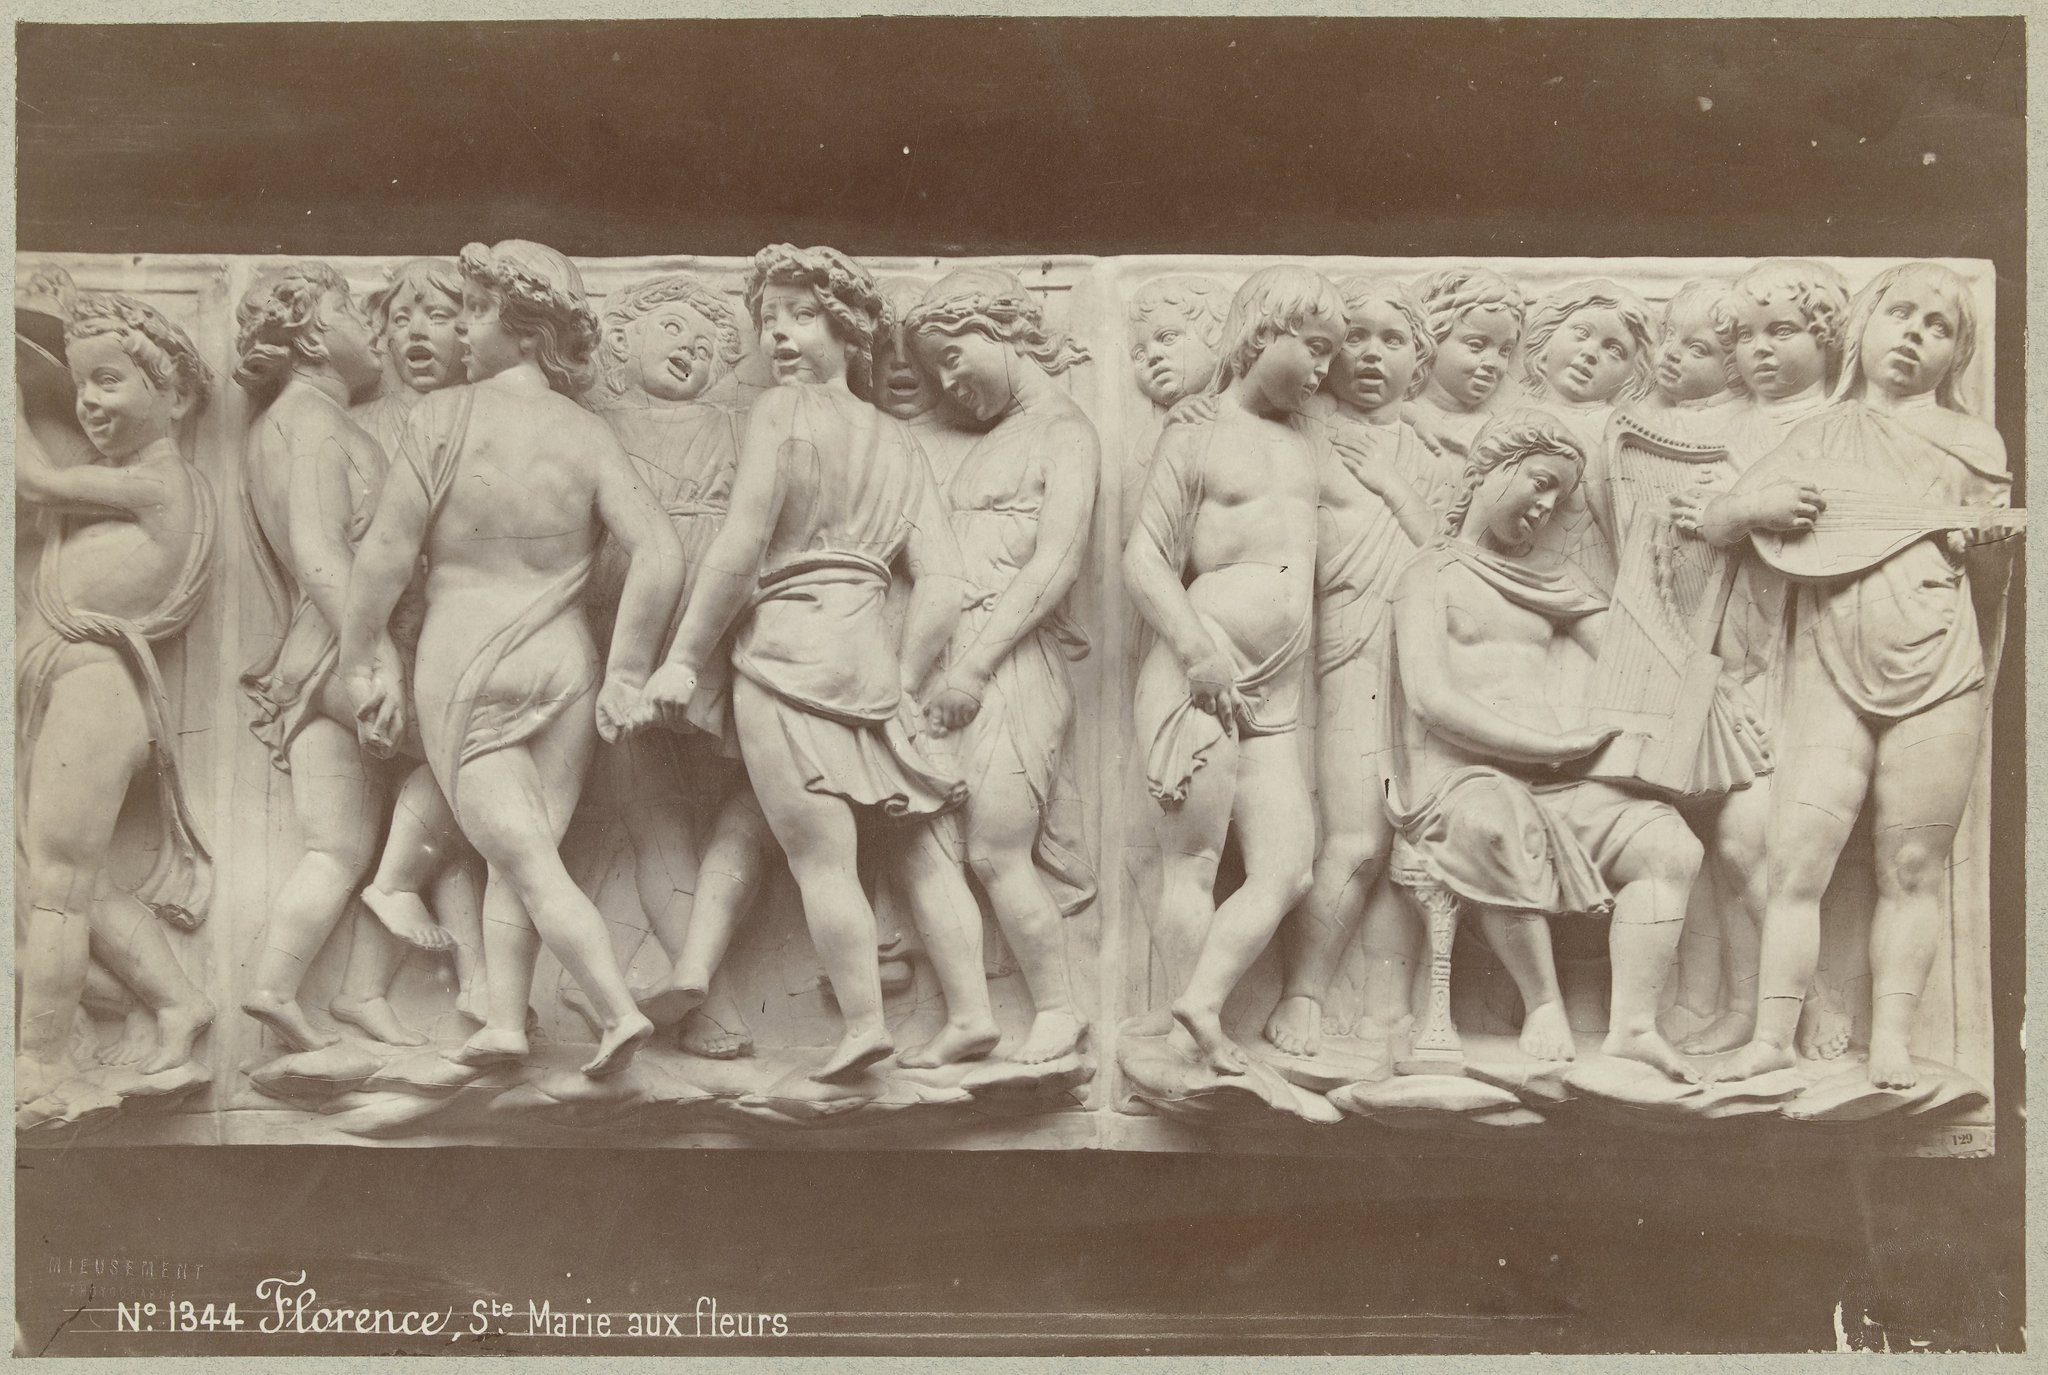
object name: photograph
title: Hoogreliëf uit het koor van de Dom van Florence, met jonge zangers en dansers, door Luca della Robbia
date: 1870-1894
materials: cardboard, paper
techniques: albumen print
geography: florence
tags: musician at work, vocal music, singing, sculpture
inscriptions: inscription: ‘Lucca d. Robbia’, inscription: ‘No. 1344 Florence, Ste. Marie aux fleurs’, collector's mark: Lugt 3937, check stamp: ‘[...]’, check stamp: ‘Mieusement/ Photographe’, inscription: ‘L a L/ I/ 48C73’, stamp: ‘Kunstboekhandel/ J.A.G. de Leur/ Photograaf-uitgever/ Huigenspark 40b/ Den Haag’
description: Tegenwoordig staat dit reliëf in het Museo dell'Opere del Duomo.